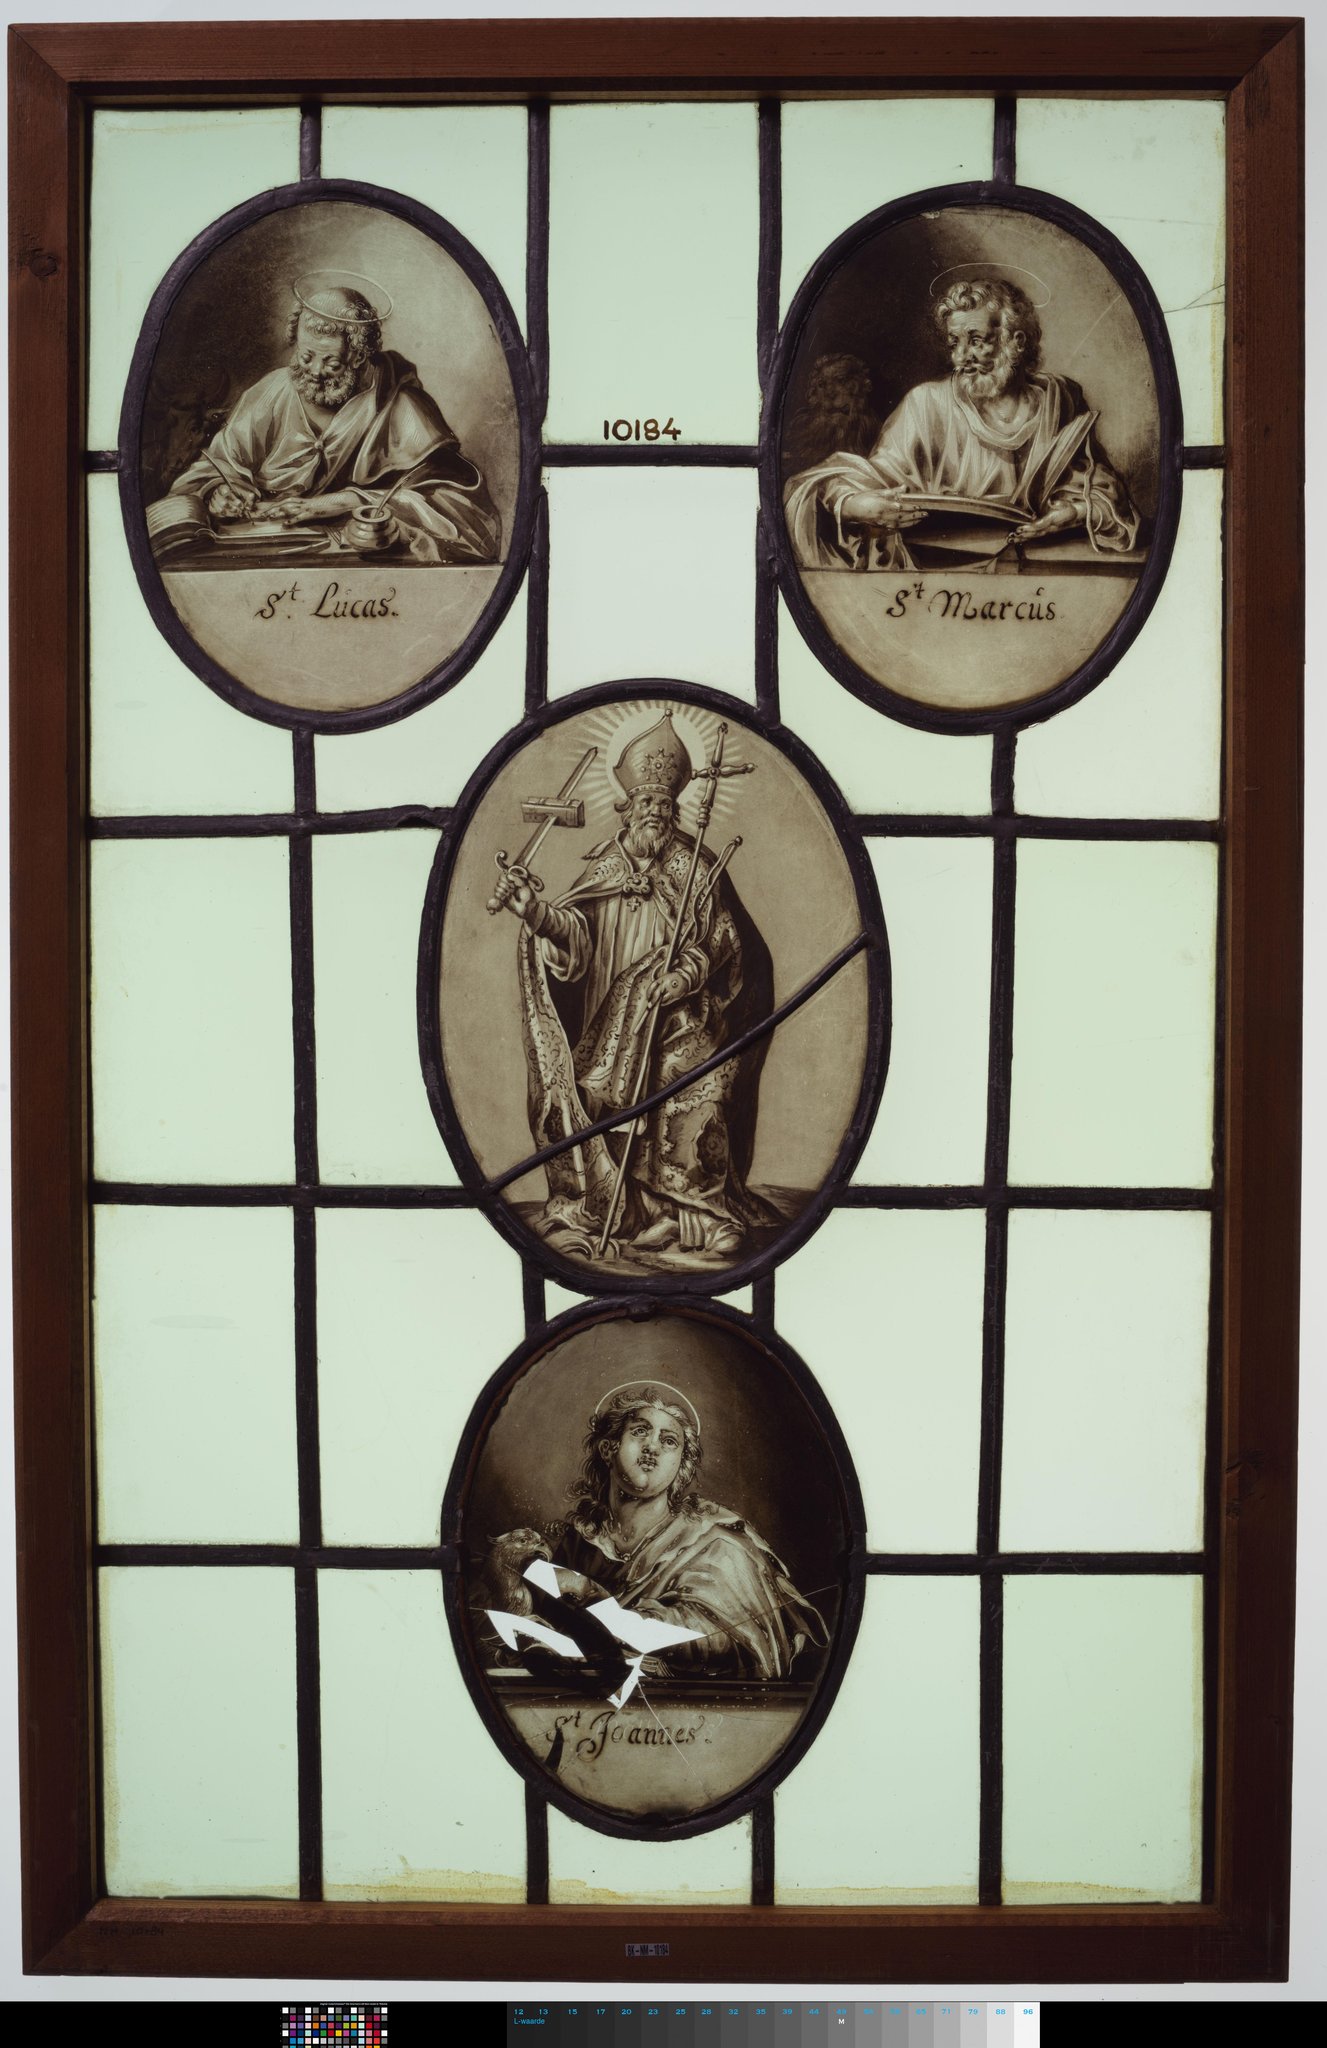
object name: light window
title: Ruit met de heilige Lucas, Marcus, Johannes en een heilige met in de ene hand een zwaard en in de andere hand een kruisstaf (Bonifacius?)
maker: Anonymous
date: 1600-1699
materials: glass, lead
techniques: leading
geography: netherlands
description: Ruit met de heilige Lucas, Marcus, Johannes en een heilige met in de ene hand een zwaard en in de andere hand een kruisstaf (Bonifacius?).